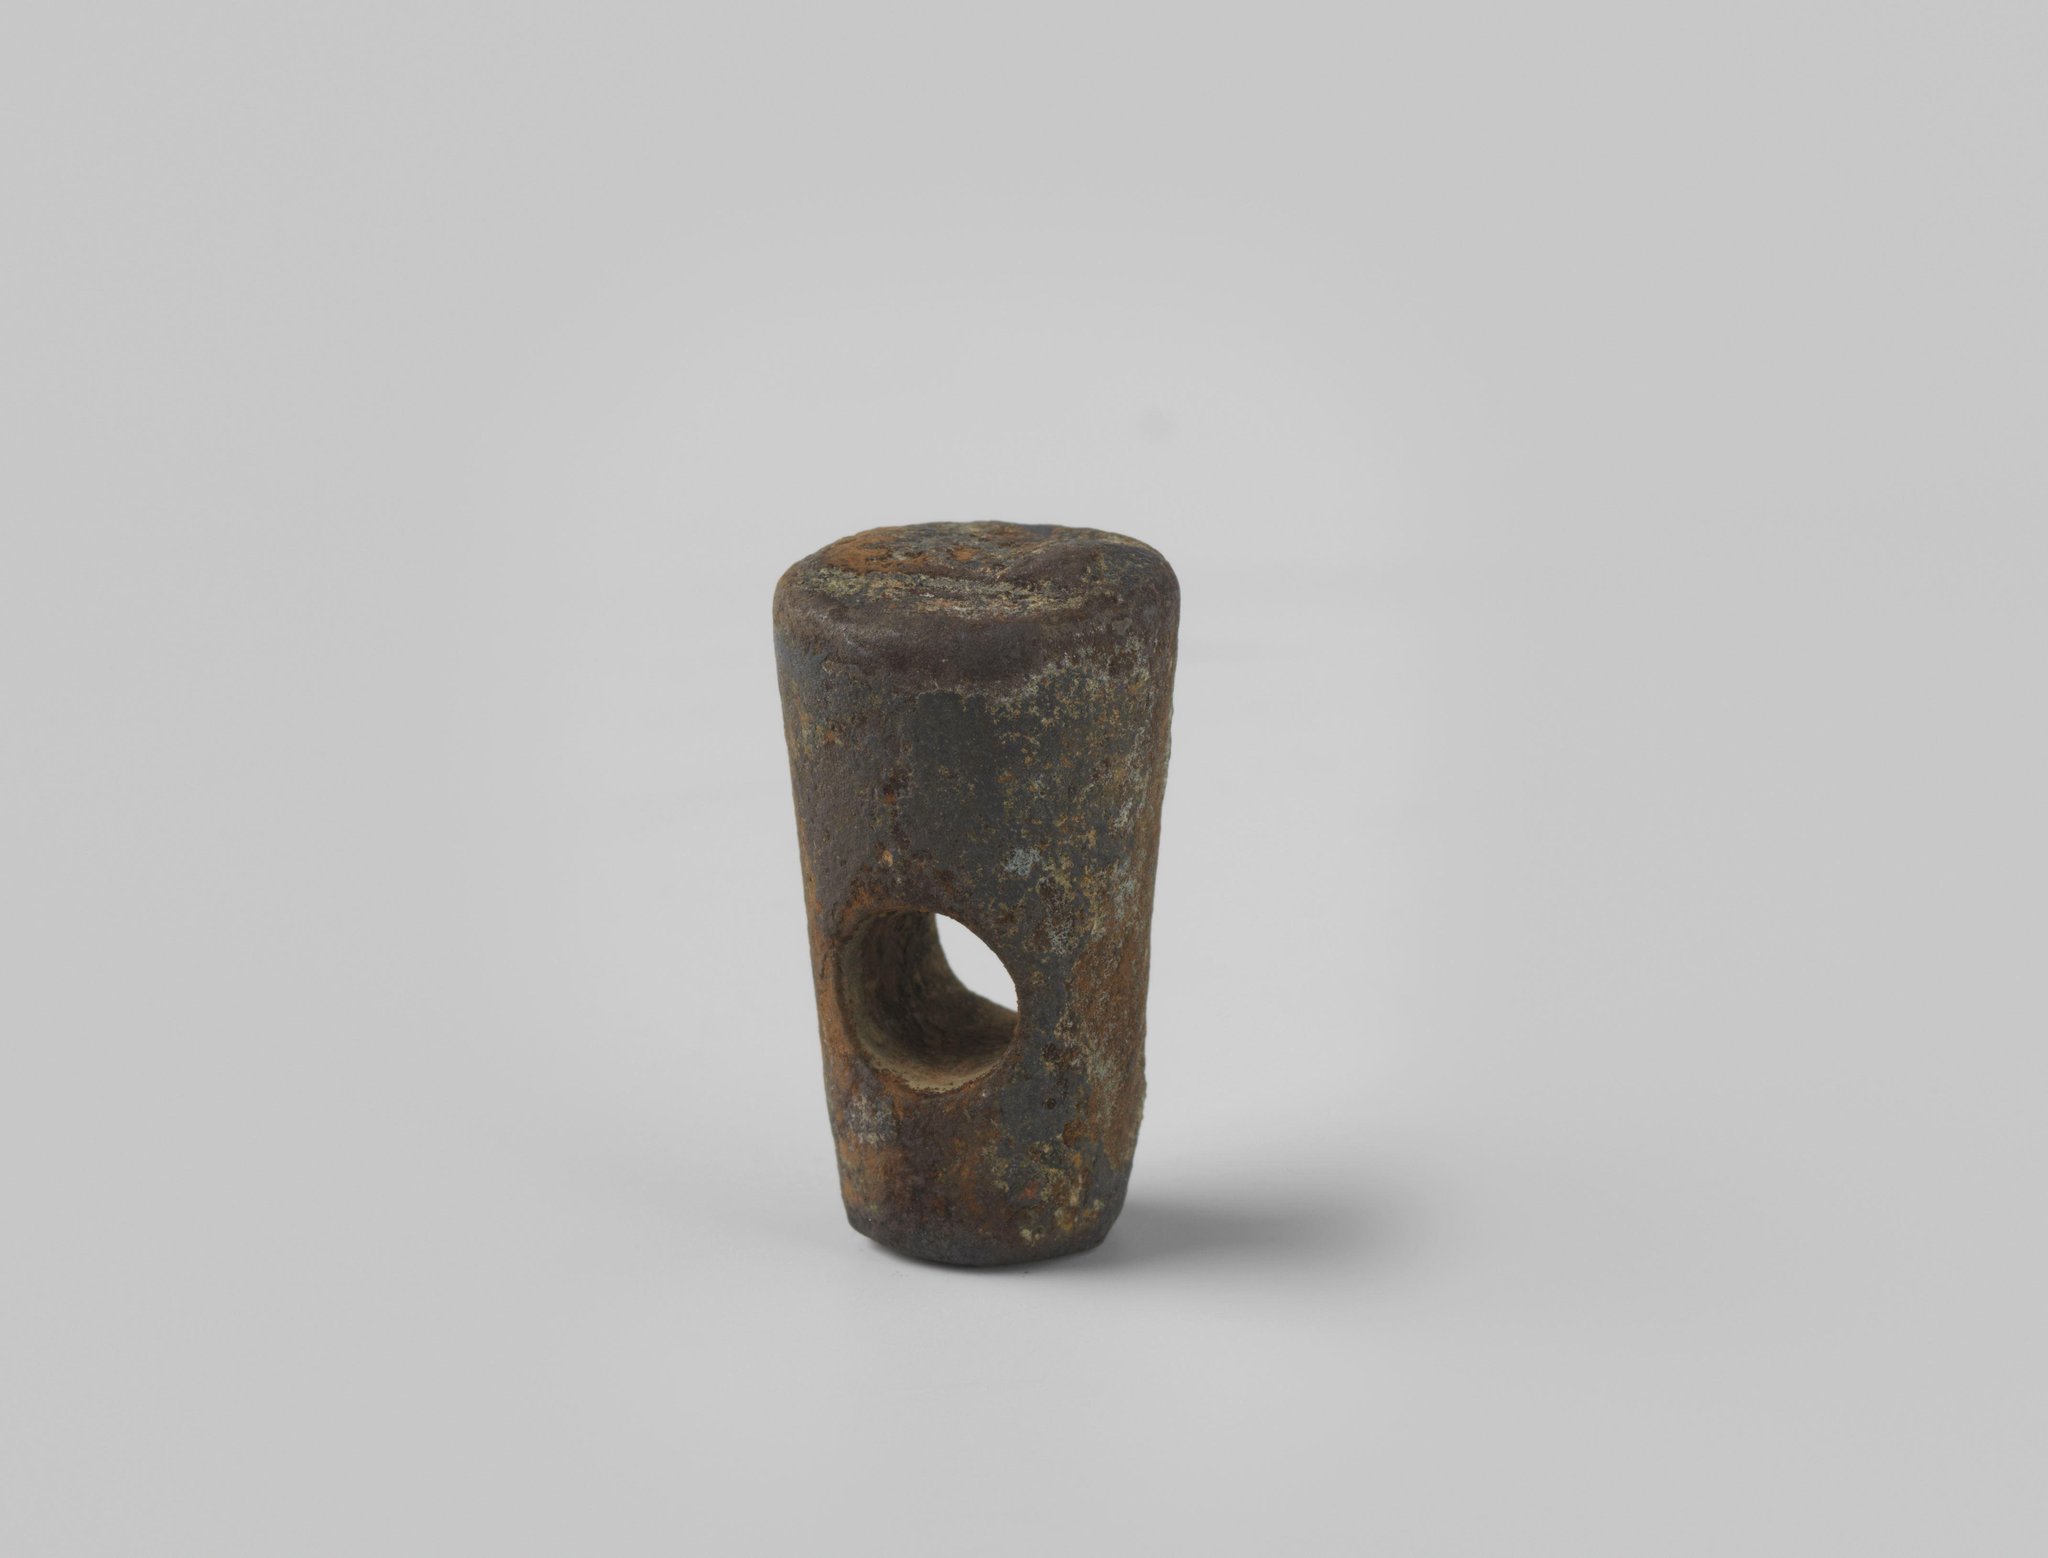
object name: spigot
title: Onderdeel van een kraan uit het wrak van de Oost-Indiëvaarder Meresteijn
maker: Anonymous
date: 1693-1702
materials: brass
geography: netherlands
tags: cape of good hope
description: Deel van een kraan: taps toelopend rond massieve tap met een dwarsgeboord gat. Tap, spigot.